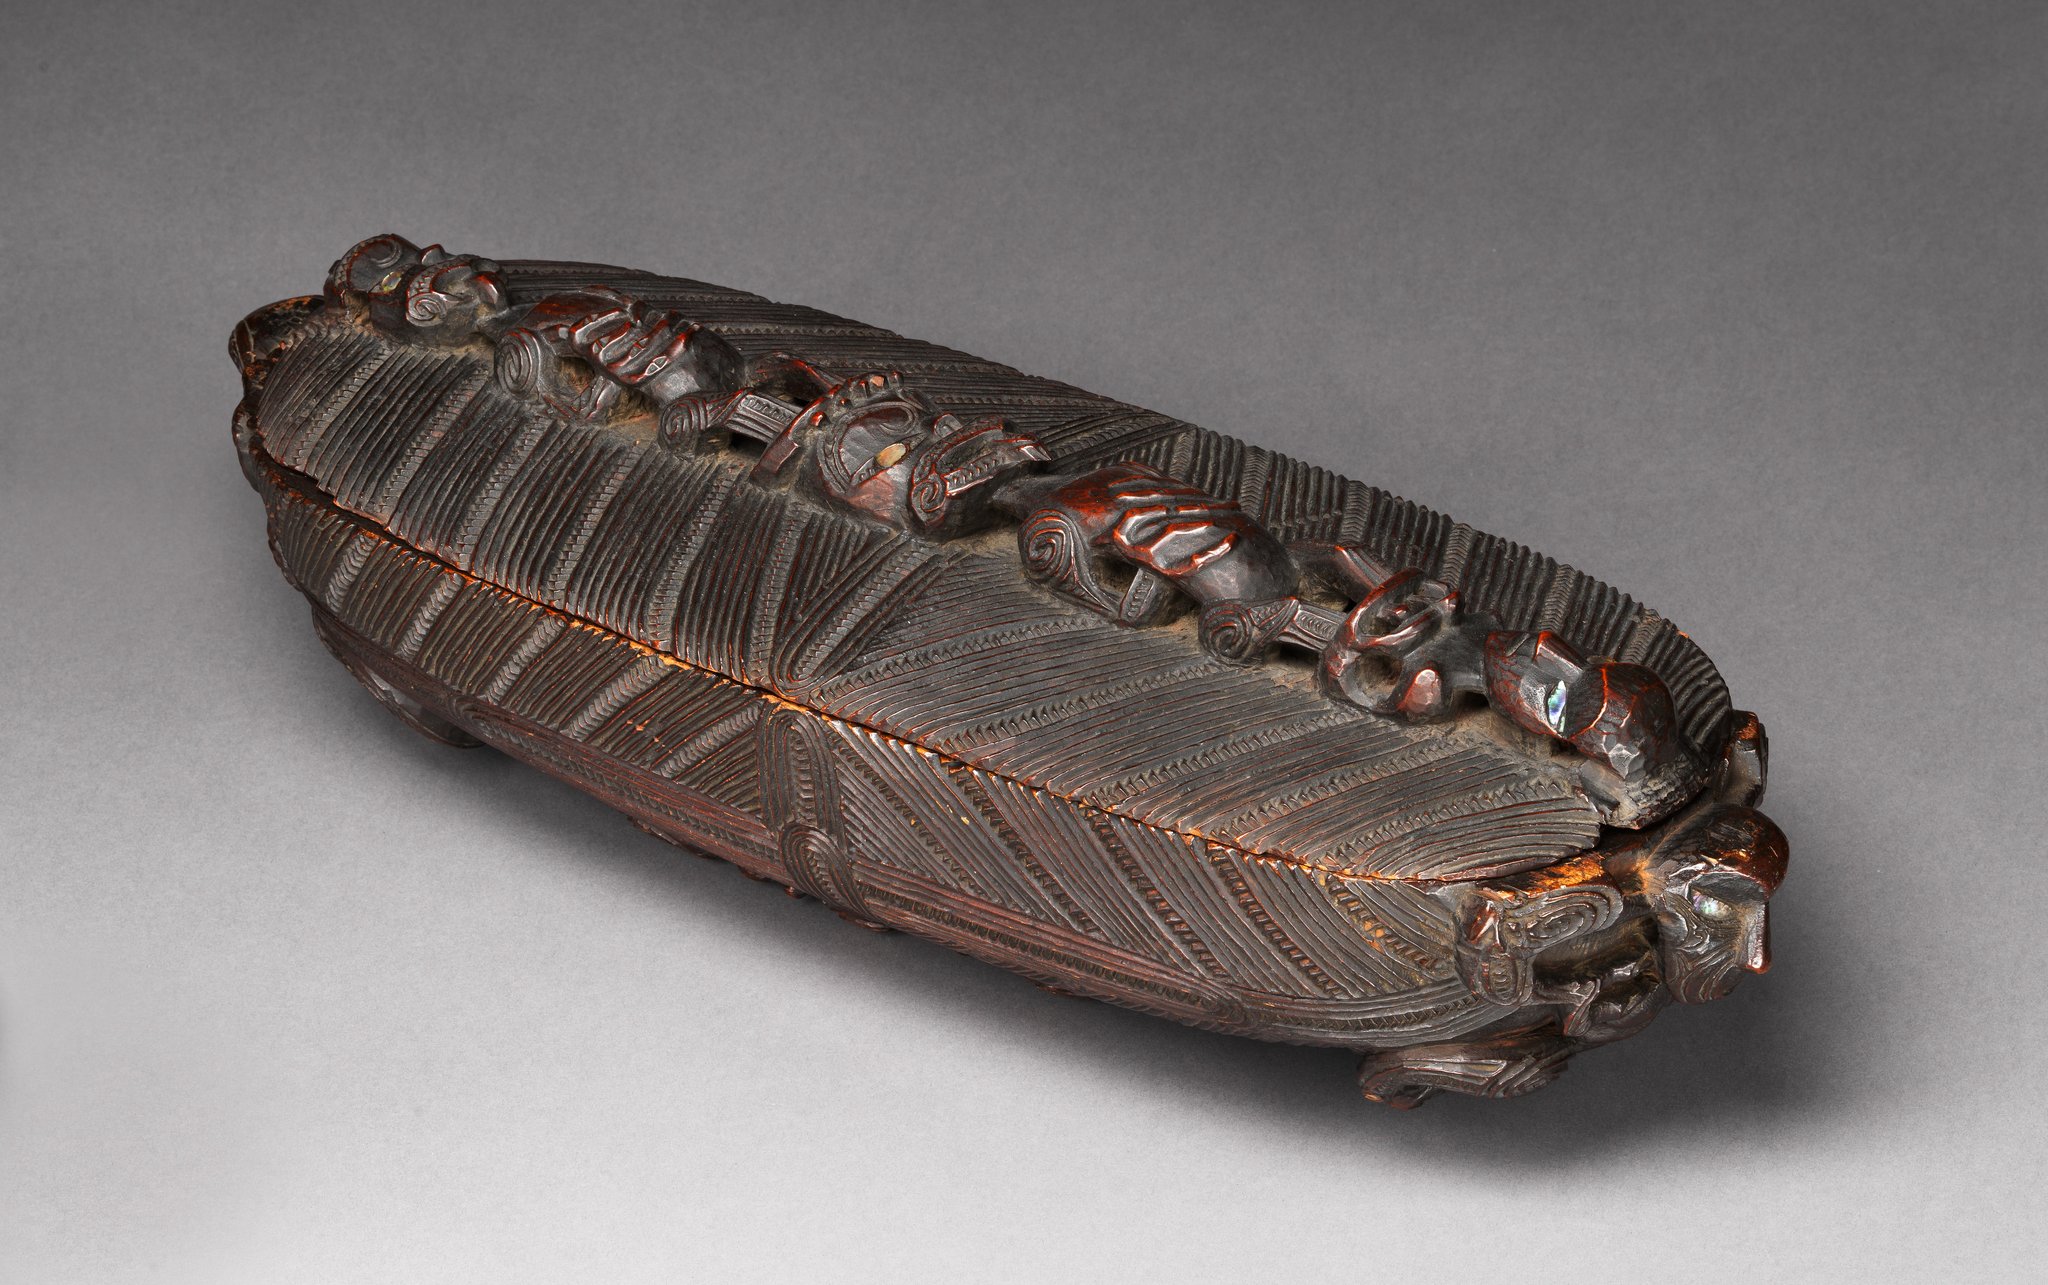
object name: box with lid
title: Treasure Box (Wakahuia)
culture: maori, te arawa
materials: mother of pearl, wood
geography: new zealand